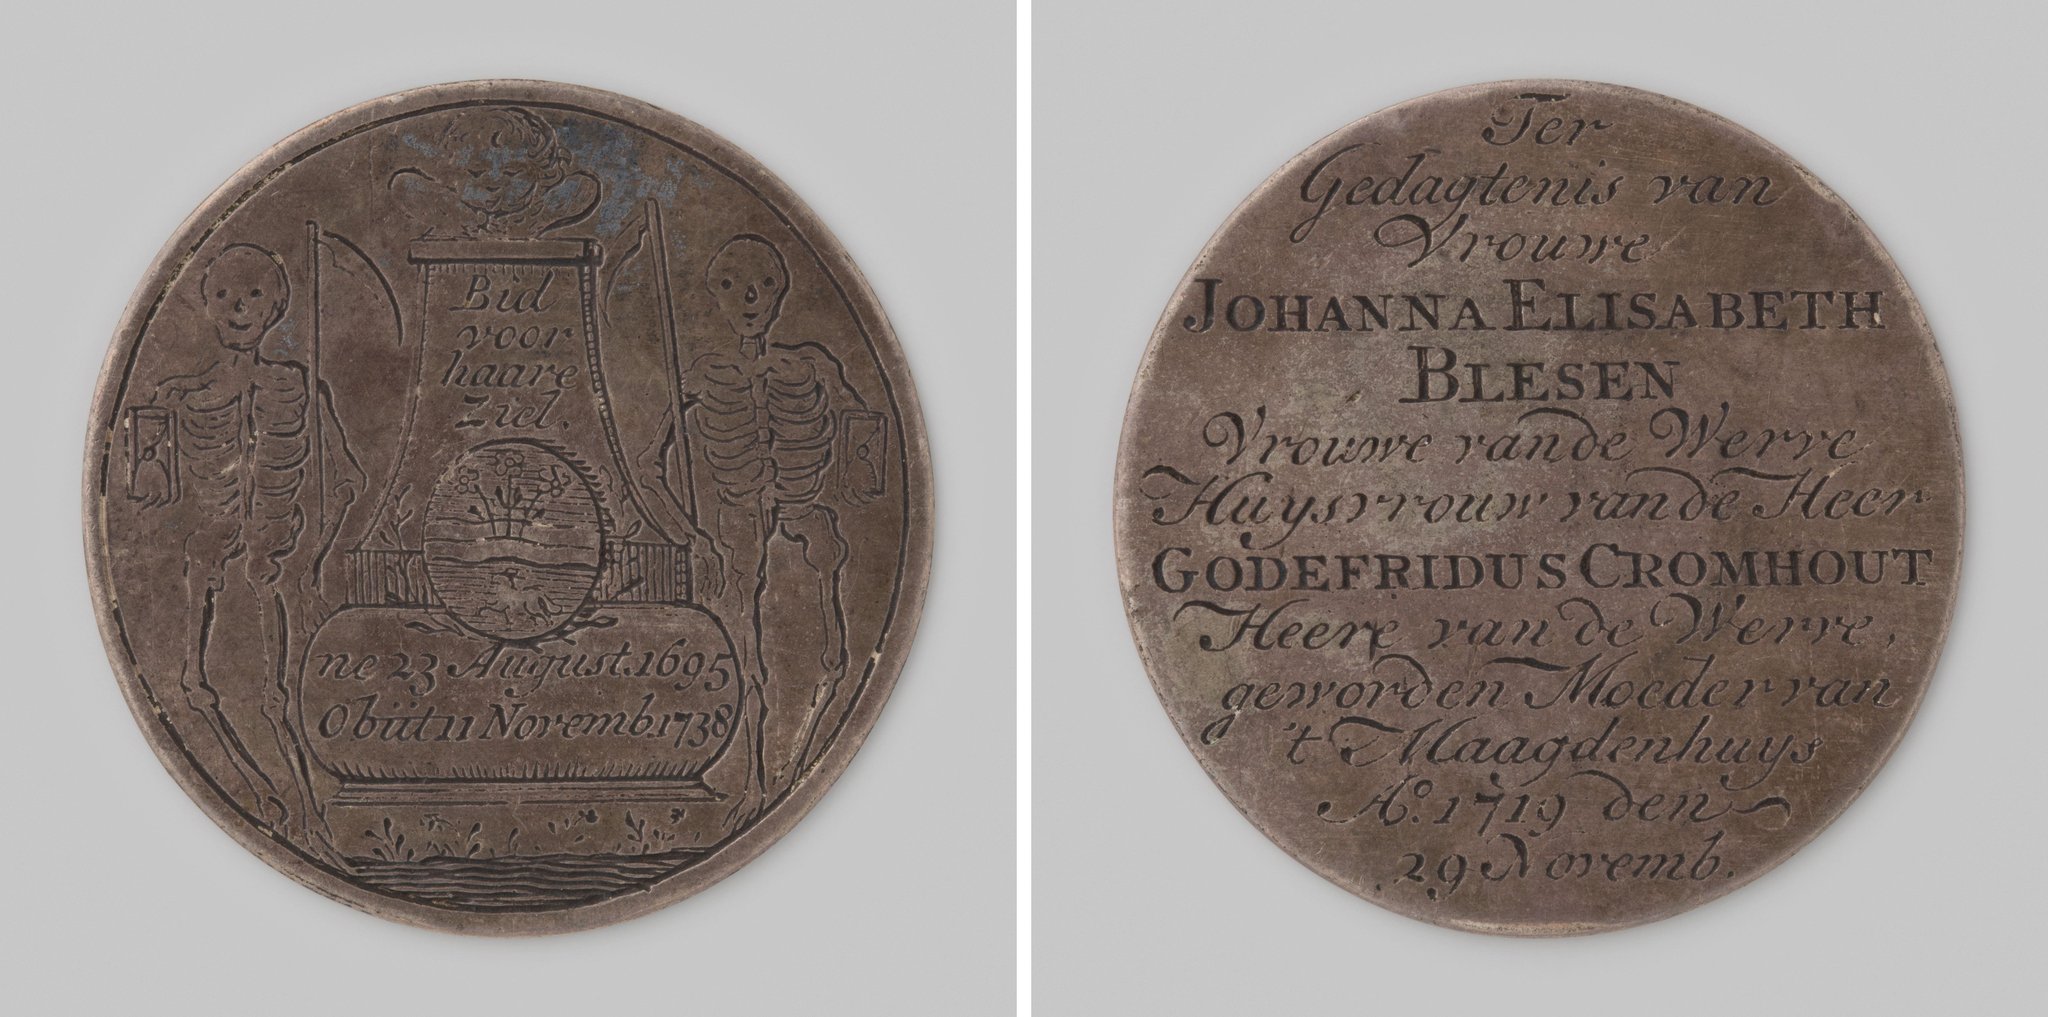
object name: family medal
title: Overlijden van Johanna Elisabeth van de Werve - Blesen, moeder van het Maagdenhuis 1738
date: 1738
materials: silver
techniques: engraving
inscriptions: inscription: ‘Ter / Gedagtenis van / Vrouwe / JOHANNA ELISABETH / BLESEN / Vrouwe van de Werve / Huysvrouw van de Heer / GODEFRIDUS CROMHOUT / Heere van de Werve, geworden Moeder van / 't Maagdenhuys / A° 1719 den / 29 Novemb.’, inscription: ‘Bid / voor / haare / Ziel. / ne 23 August. 1695 /Obiit 11 Novemb. 1738’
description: Gegraveerde ronde plaat zilver, op de voorzijde een beschreven grafmonument met familiewapen tussen twee skeletten, elk met zeis en zandloper, op de keerzijde dertien regels tekst.